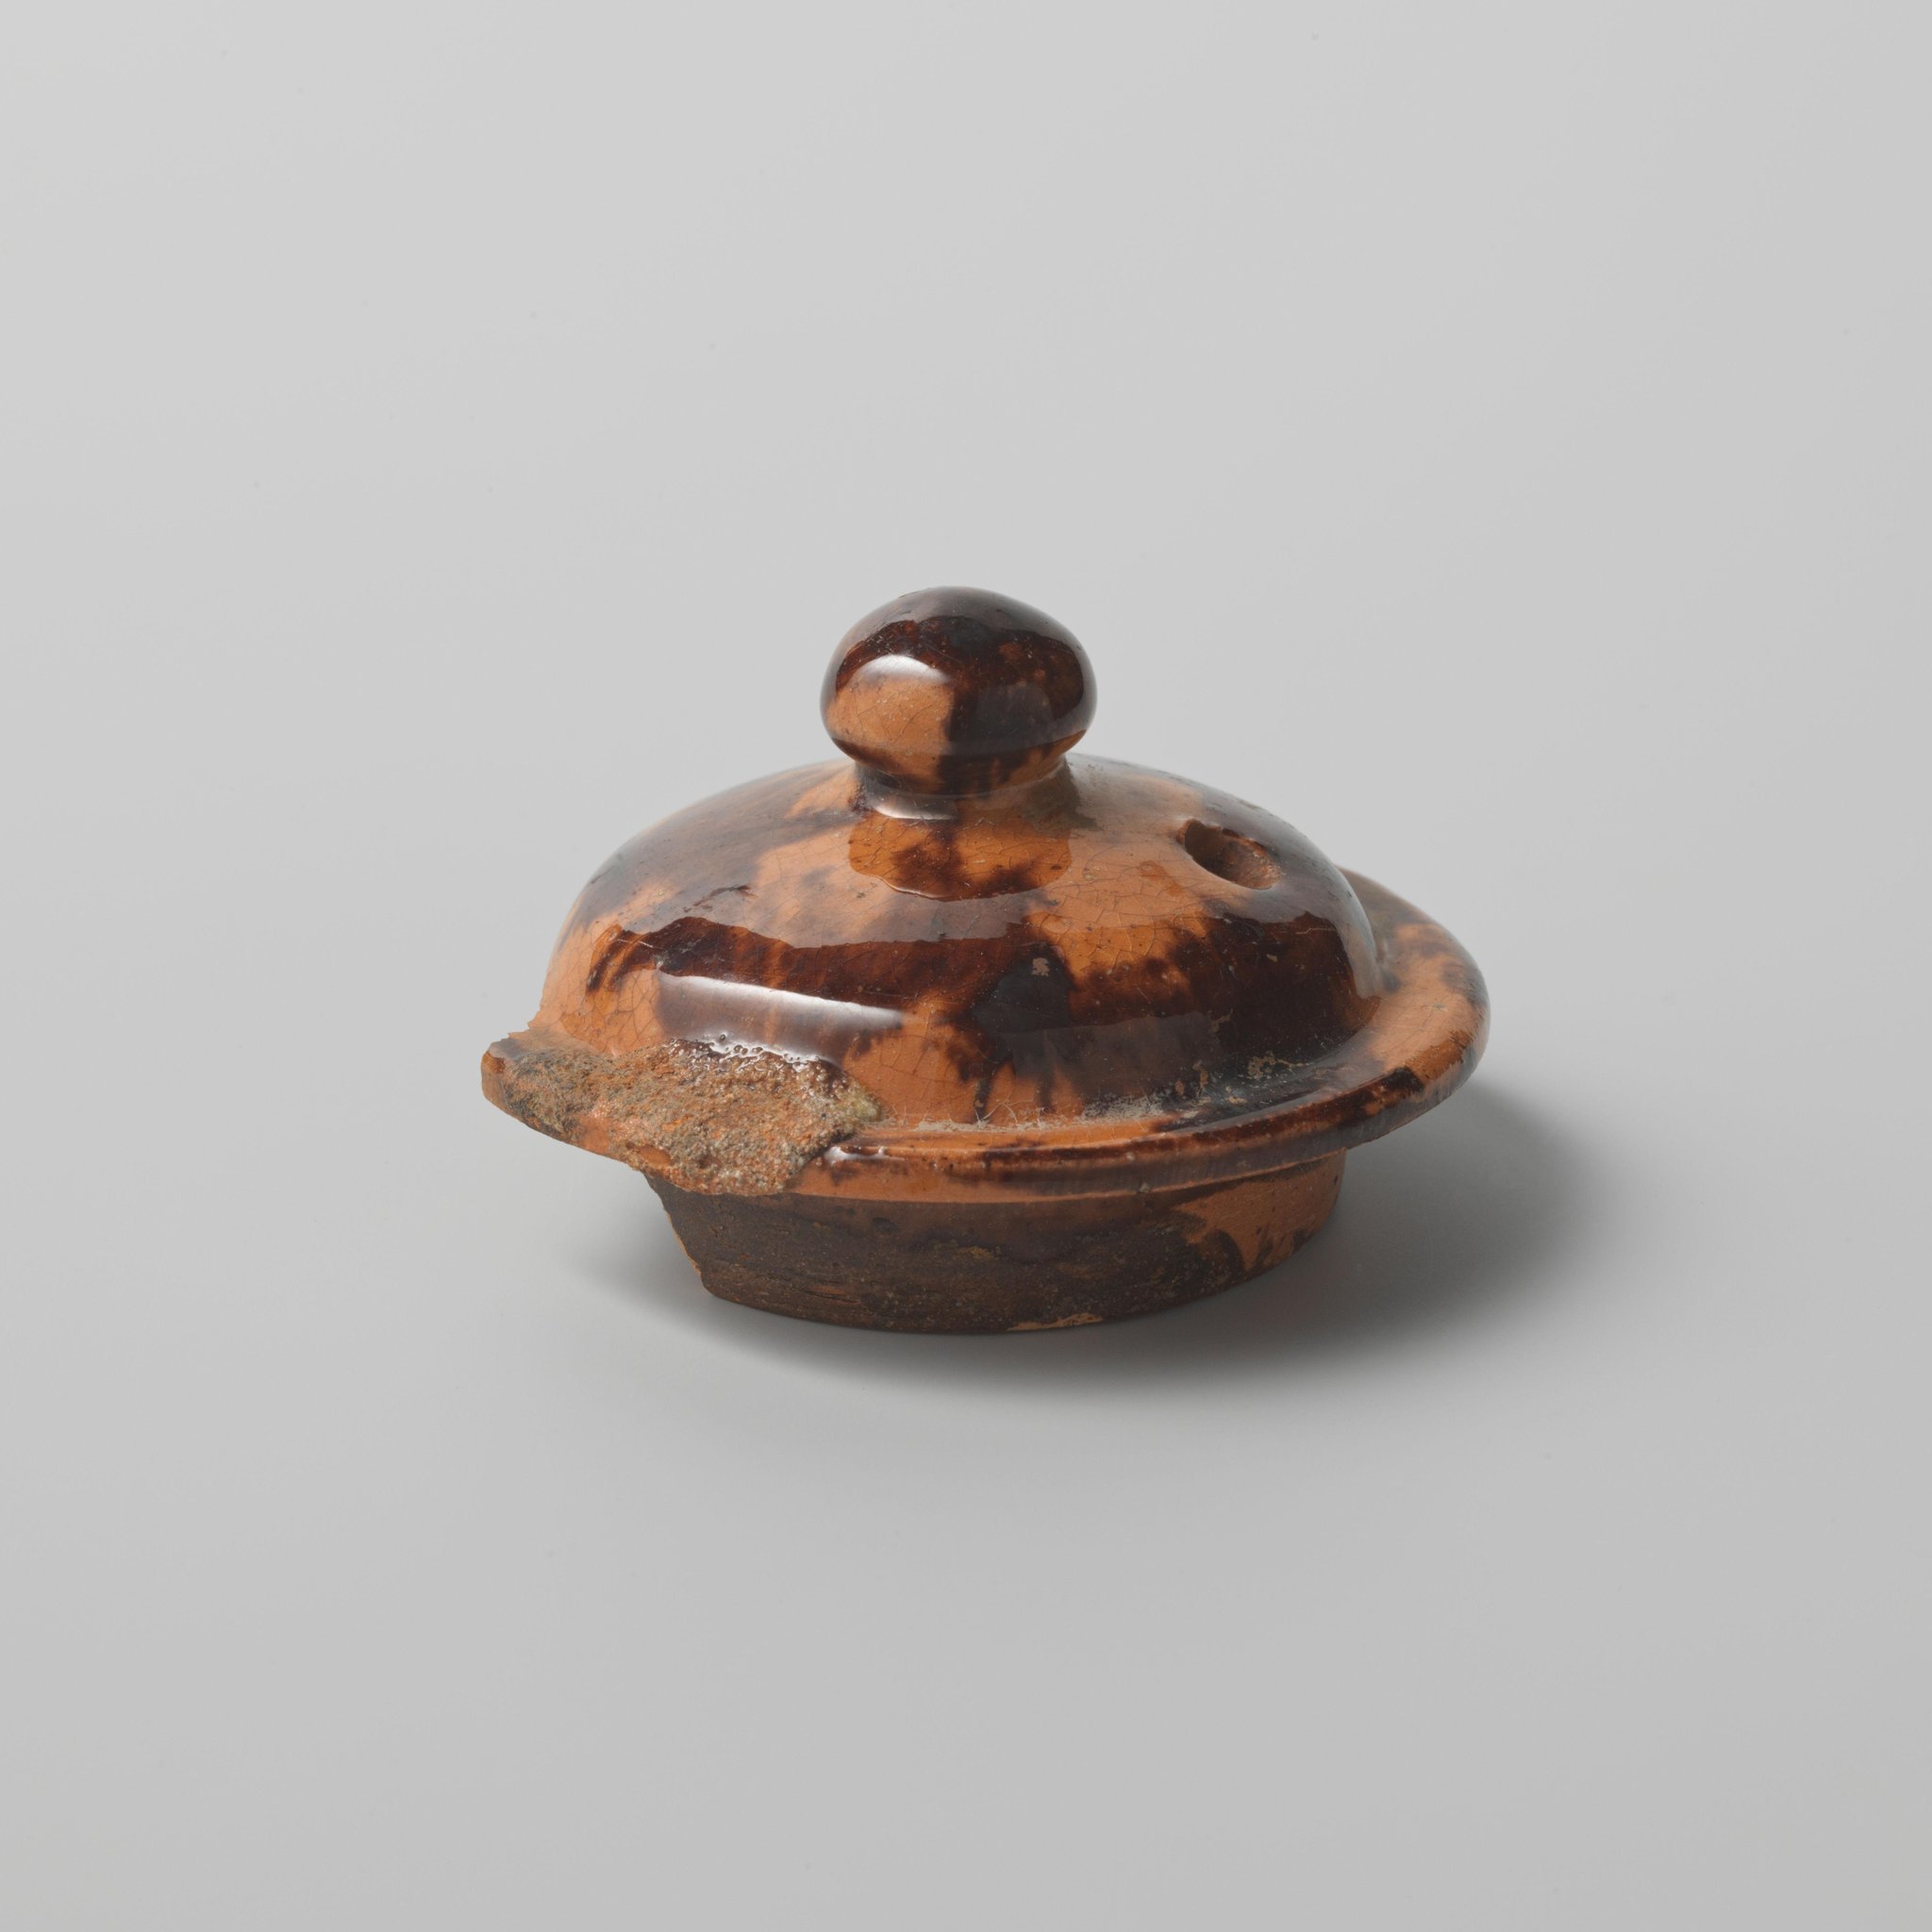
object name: lid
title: Deksel van een theepot met bruine vlekken (De Caluwe bakafval)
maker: jacobus de caluwe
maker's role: plateelbakkerij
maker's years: -1730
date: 1700-1725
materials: earthenware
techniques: firing, vitrification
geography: delft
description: Toegeschreven aan Jacobus de Caluwe, omdat dit voorwerp samen met gemerkte stukken (‘Jacobus De Caluwe’ en rennend hert) gevonden is op de plaats waar zich De Caluwes tweede werkplaats bevond. Er is een duidelijke stilistische overeenkomst tussen de gemerkte en niet gemerkte voorwerpen uit deze archeologische vondst.